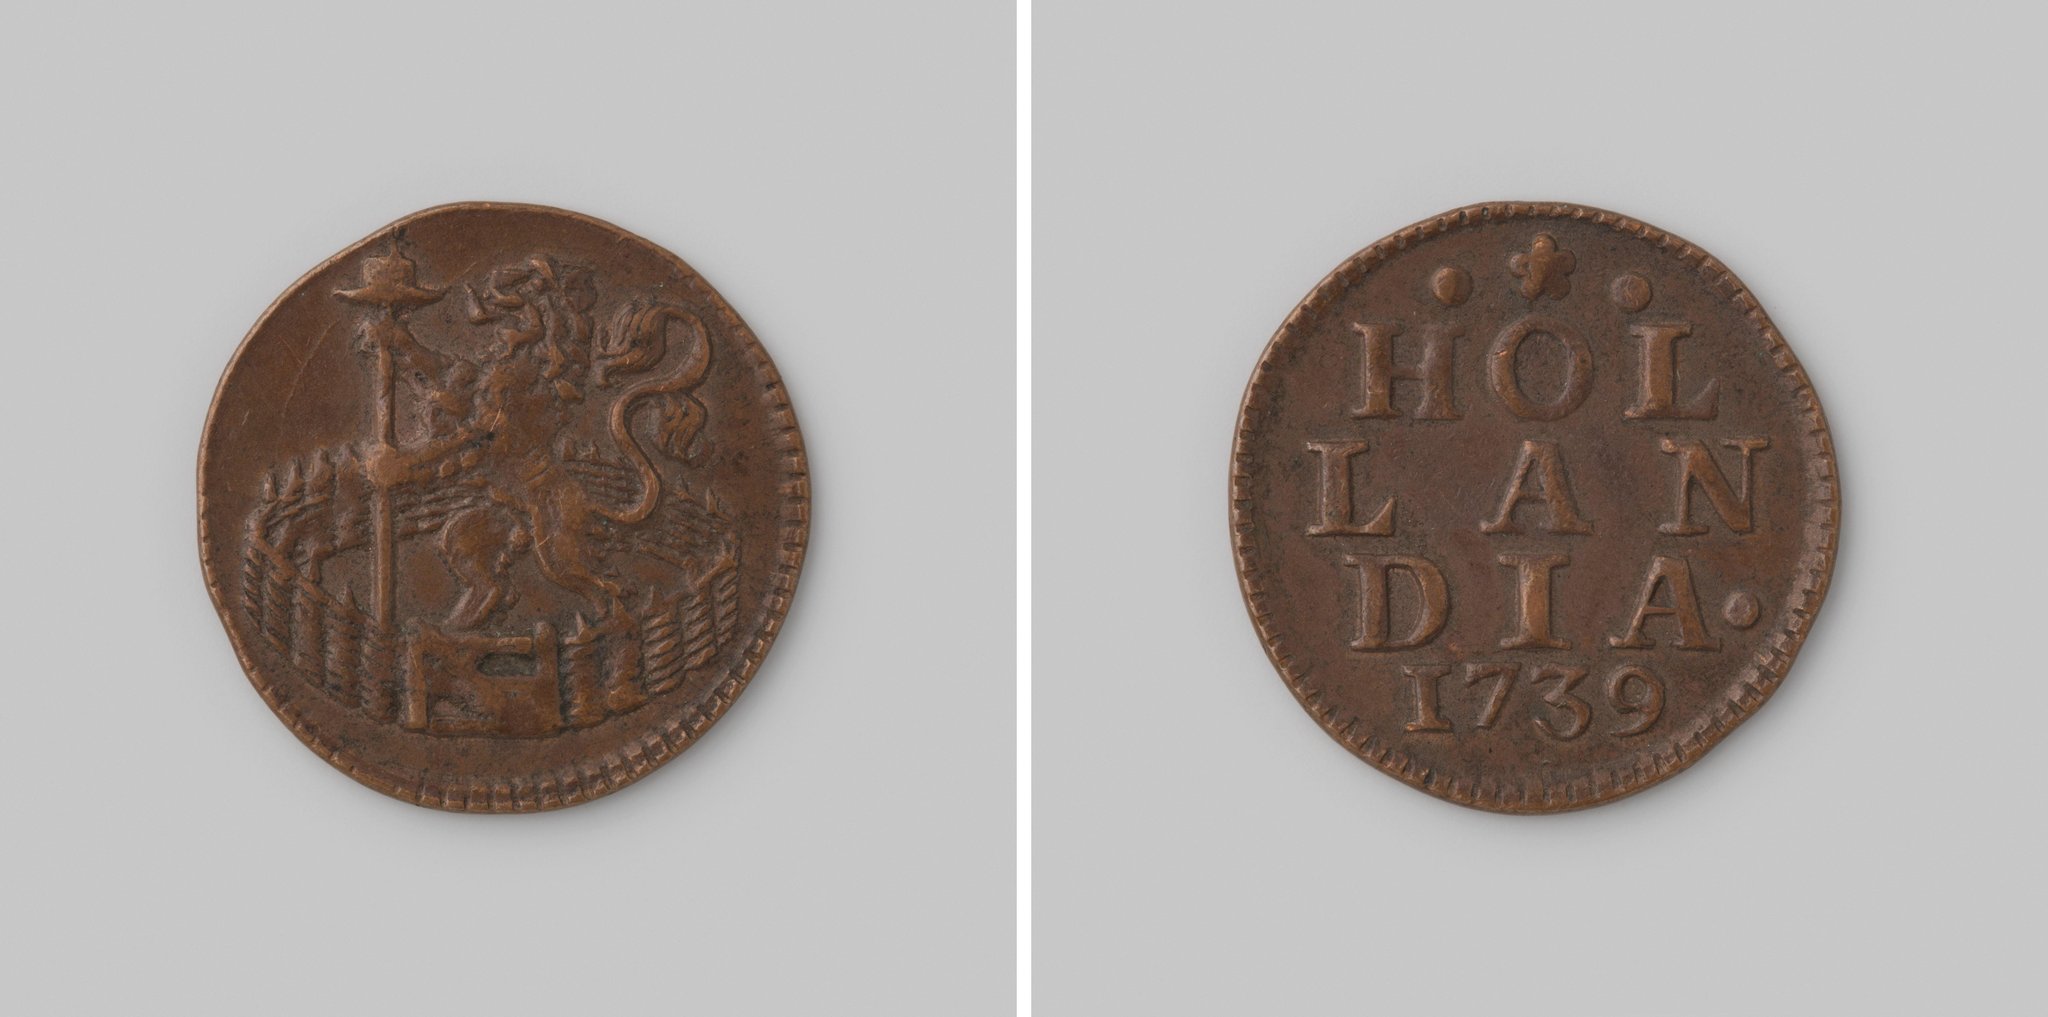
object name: coin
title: Hollandse duit, 1739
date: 1739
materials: copper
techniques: striking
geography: dordrecht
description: Koperen munt. Voorzijde: binnen omheining staande leeuw met vrijheidshoed op speer. Keerzijde: opschrift: provincienaam in drie regels, daaronder jaartal.